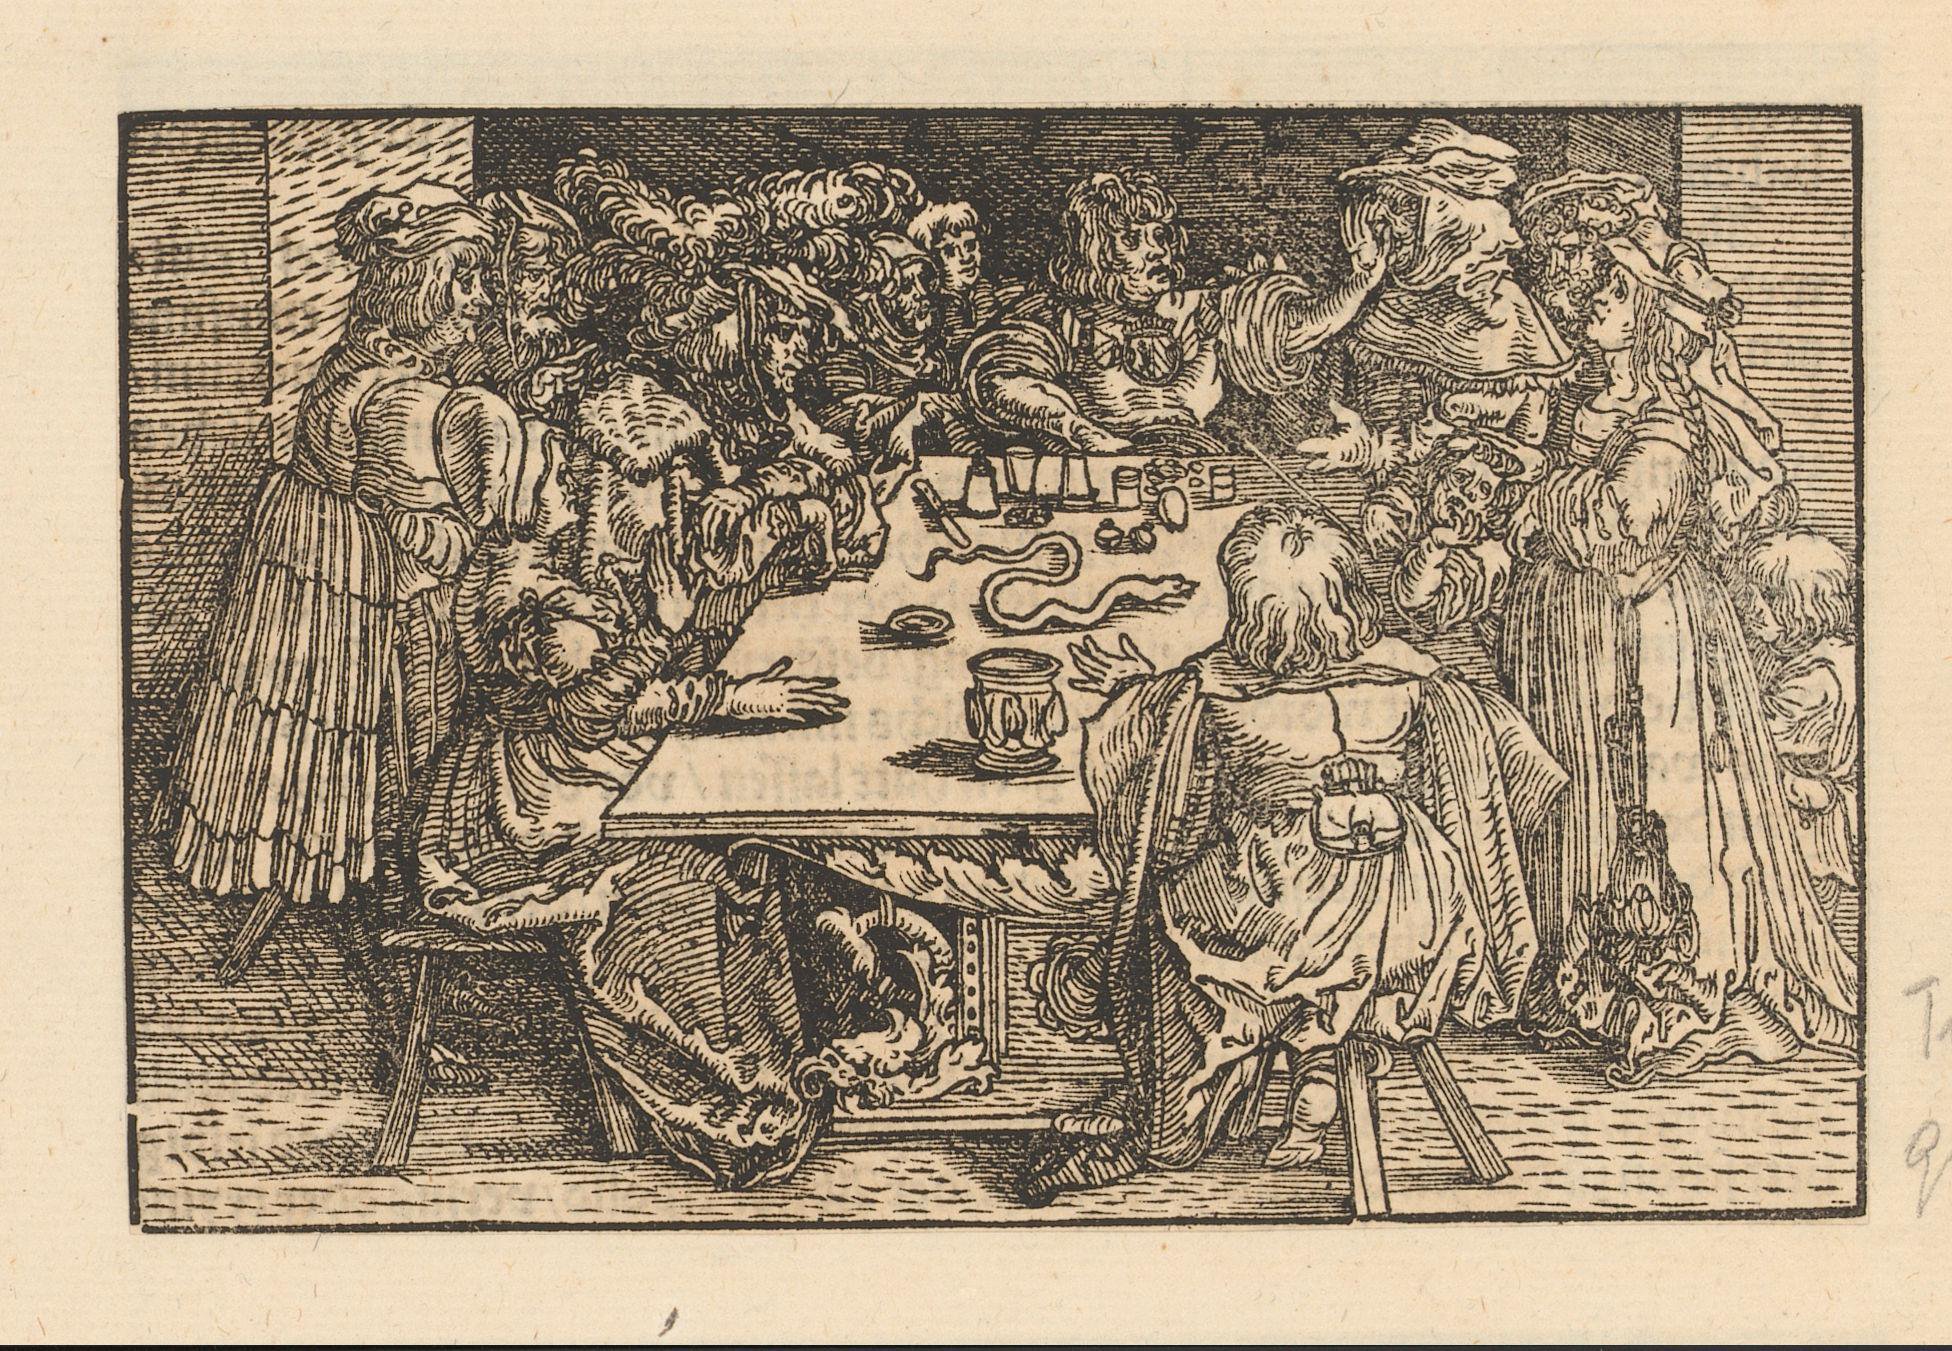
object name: album leaf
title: Goochelaar vermaakt zijn publiek aan een tafel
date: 1514-1532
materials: paper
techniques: letterpress printing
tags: divination, prognostication ~ magic, sorcerer, magician, wizard, warlock, the show; fair and circus performers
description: Deze prent is gebruikt in: Petrarca, Francesco. Von der Artzney bayder Glück, des guten und widerwertigen: unnd weß sich ain yeder inn Gelück und Unglück halten sol (...). Augsburg: Heinrich Steiner, 1532. Deze uitgave is ook bekend onder de titel 'Trostspiegel in Glück und Unglück'. Deze prent is ook gebruikt in: Cicero, Marcus Tulius. Officia M.T.C. Ein Buch so Marcus Tullius Cicero der Römer zu seynem (...). [Vertaald uit het Latijn door] Johann von Schwarzenberg. Augsburg: Heinrich Steiner, 1531.